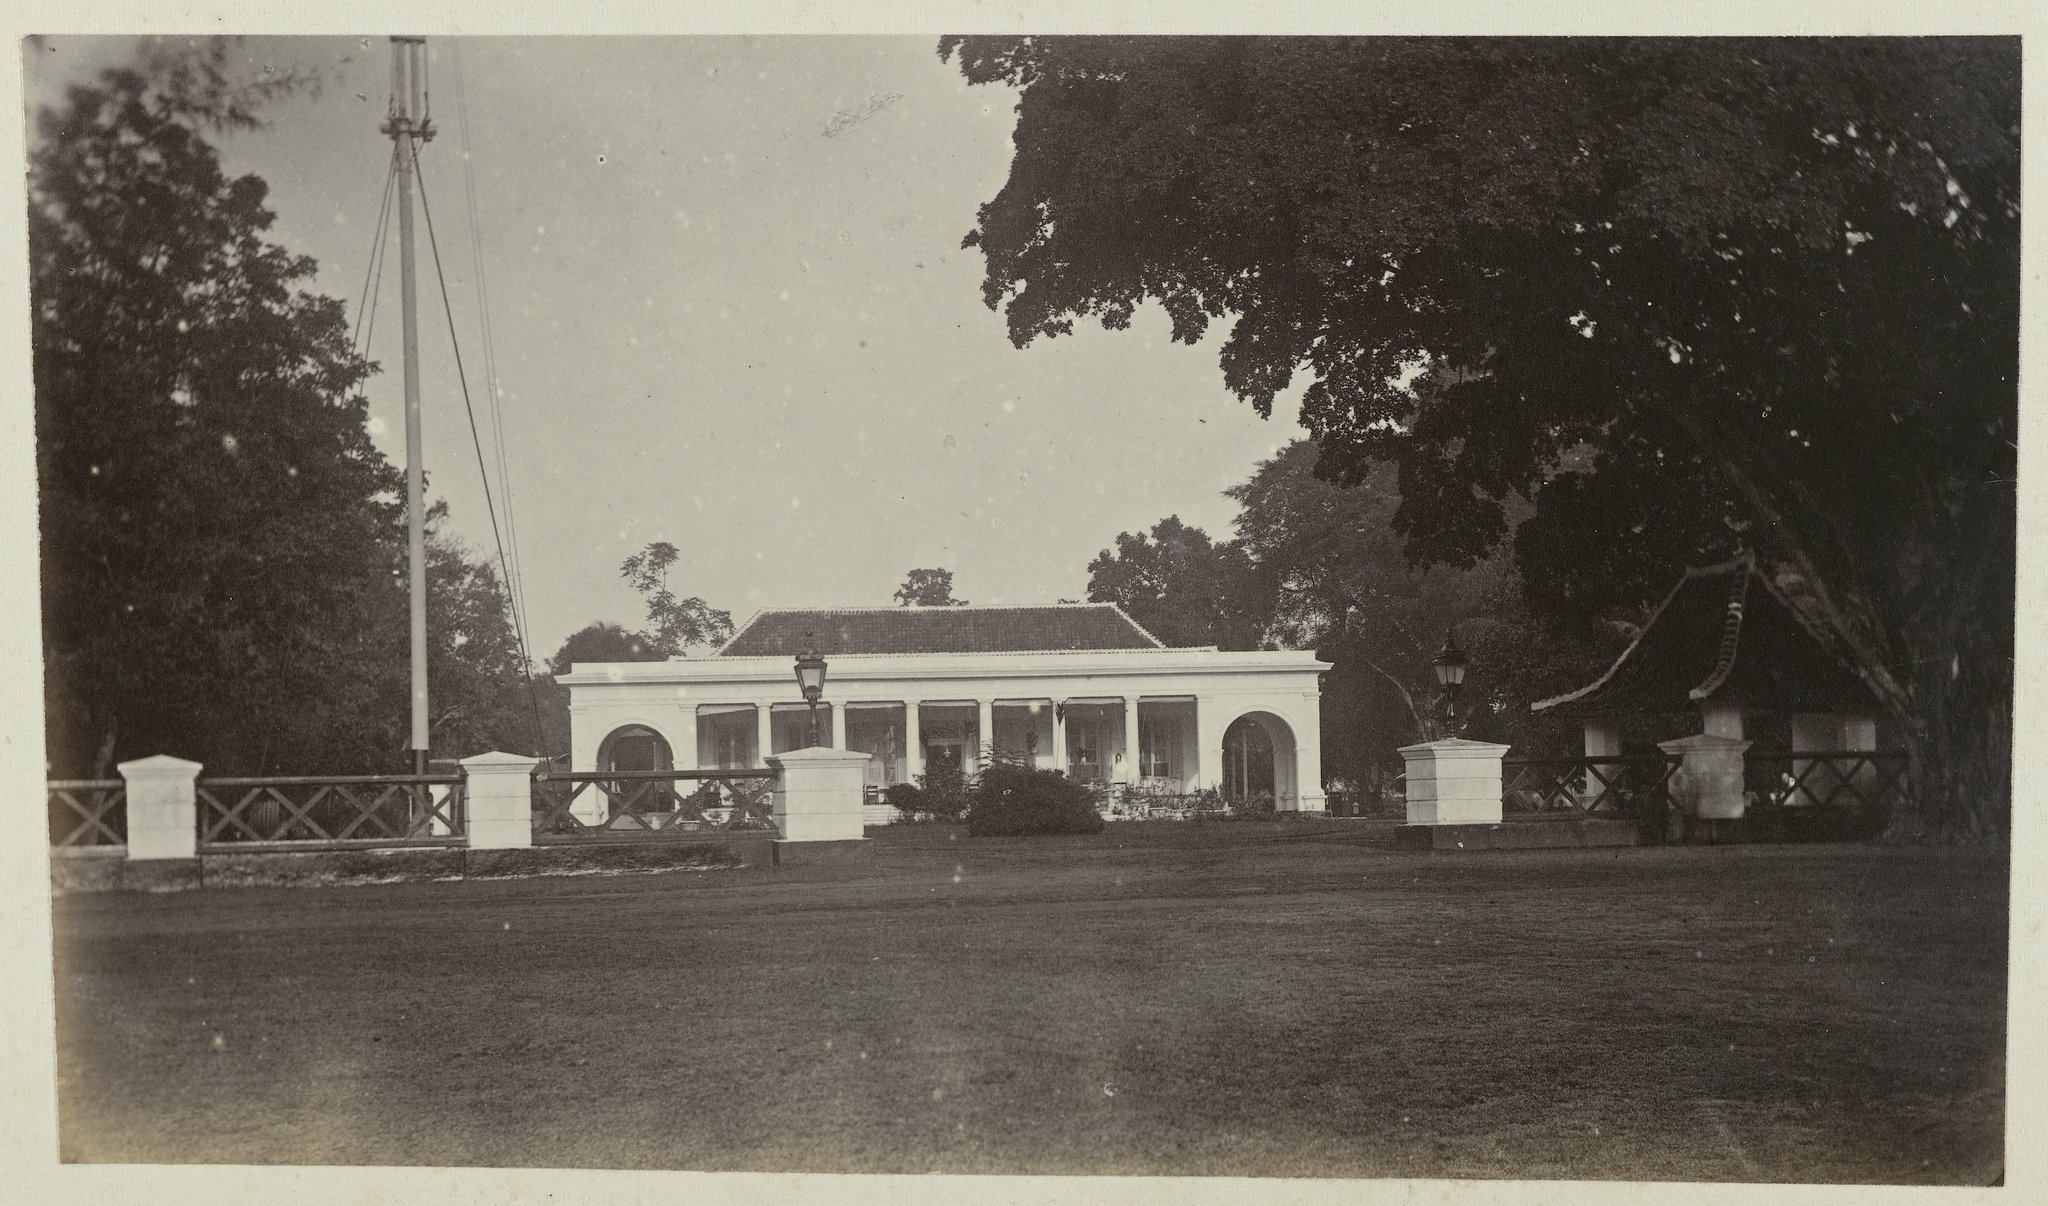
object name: photograph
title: Woonhuis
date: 1863-1869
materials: photographic support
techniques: albumen print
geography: java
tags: country-house, java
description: Een woonhuis gezien vanaf de weg. Onderdeel van het groene fotoalbum met foto's van Java, uit het bezit van apotheker Specht-Grijp, die in 1865 vanuit Batavia naar Nederland terugkeerde.